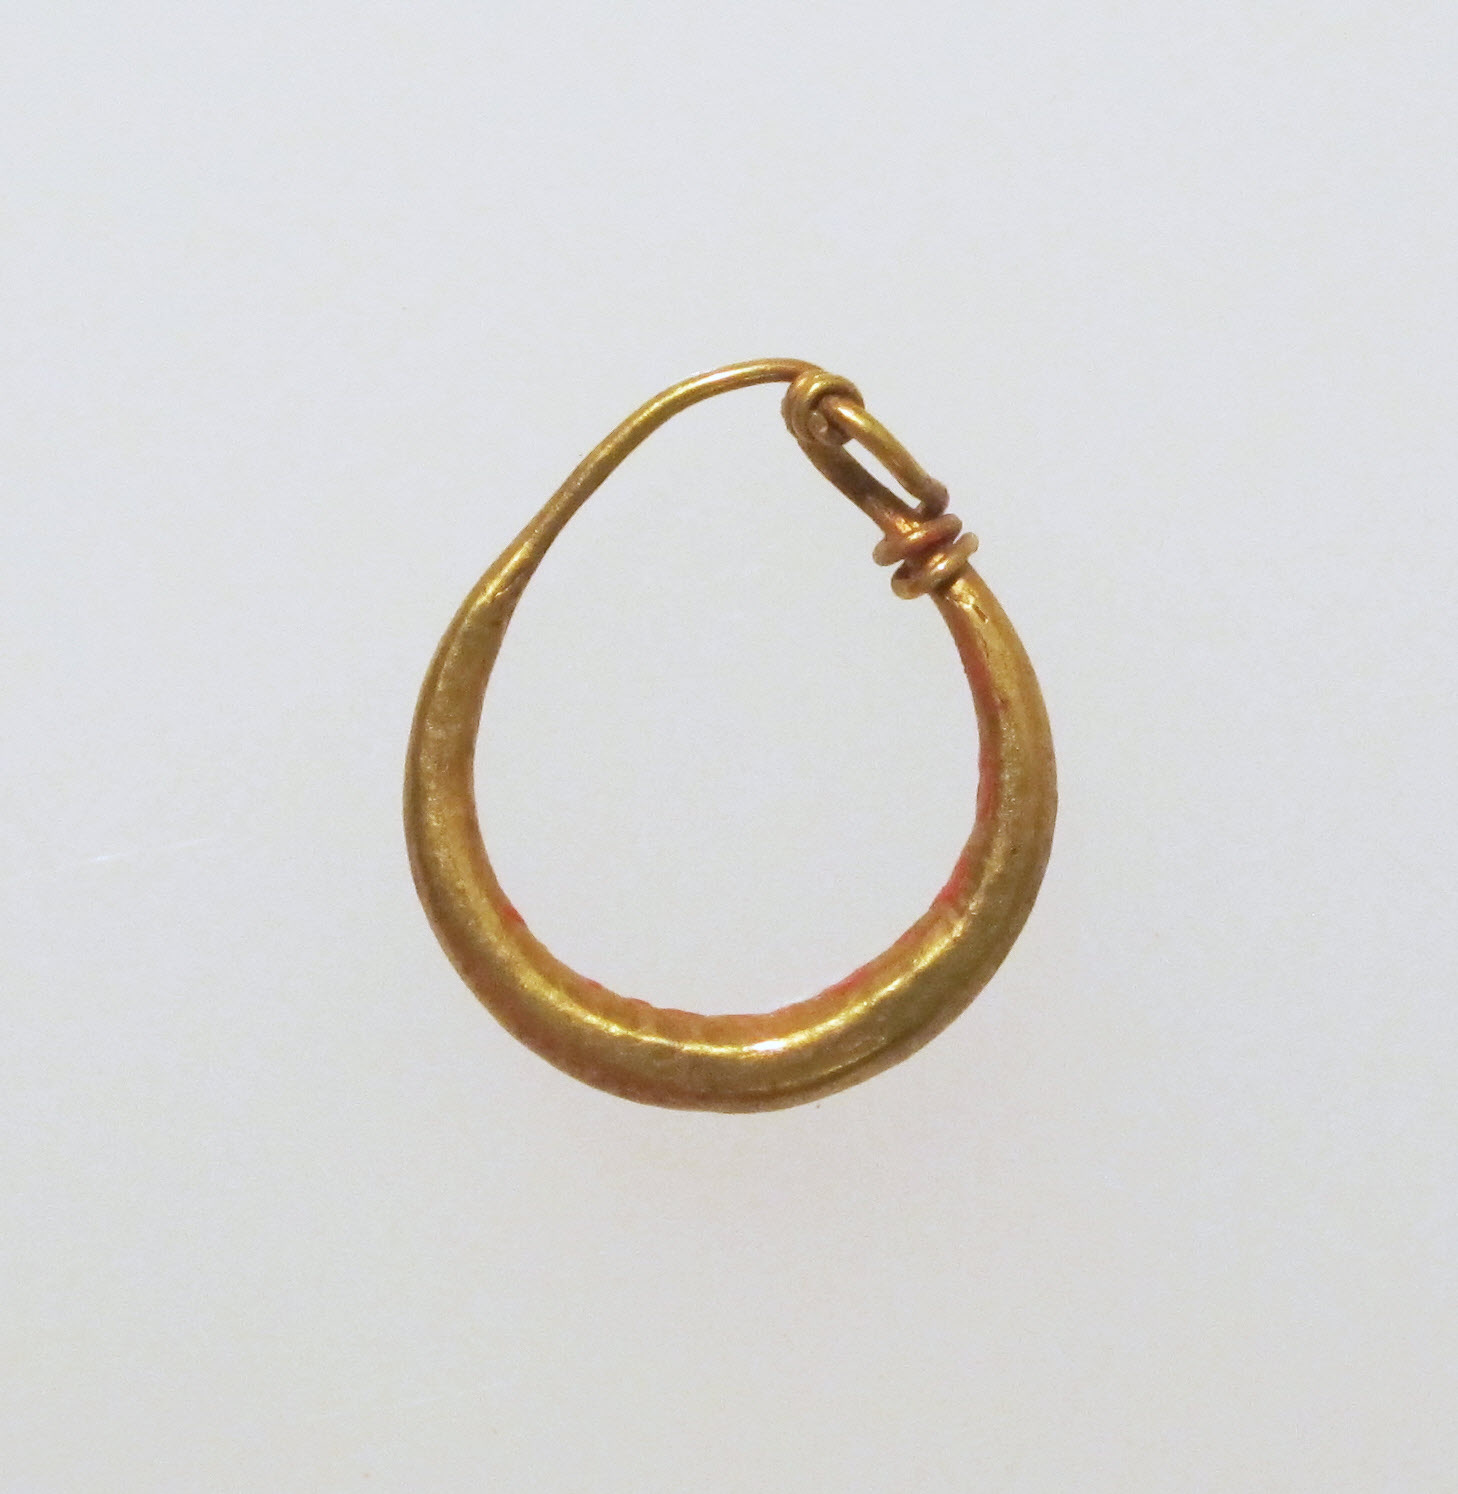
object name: earring loop type, plain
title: Earring-loop type, plain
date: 7000 BCE-330 CE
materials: gold